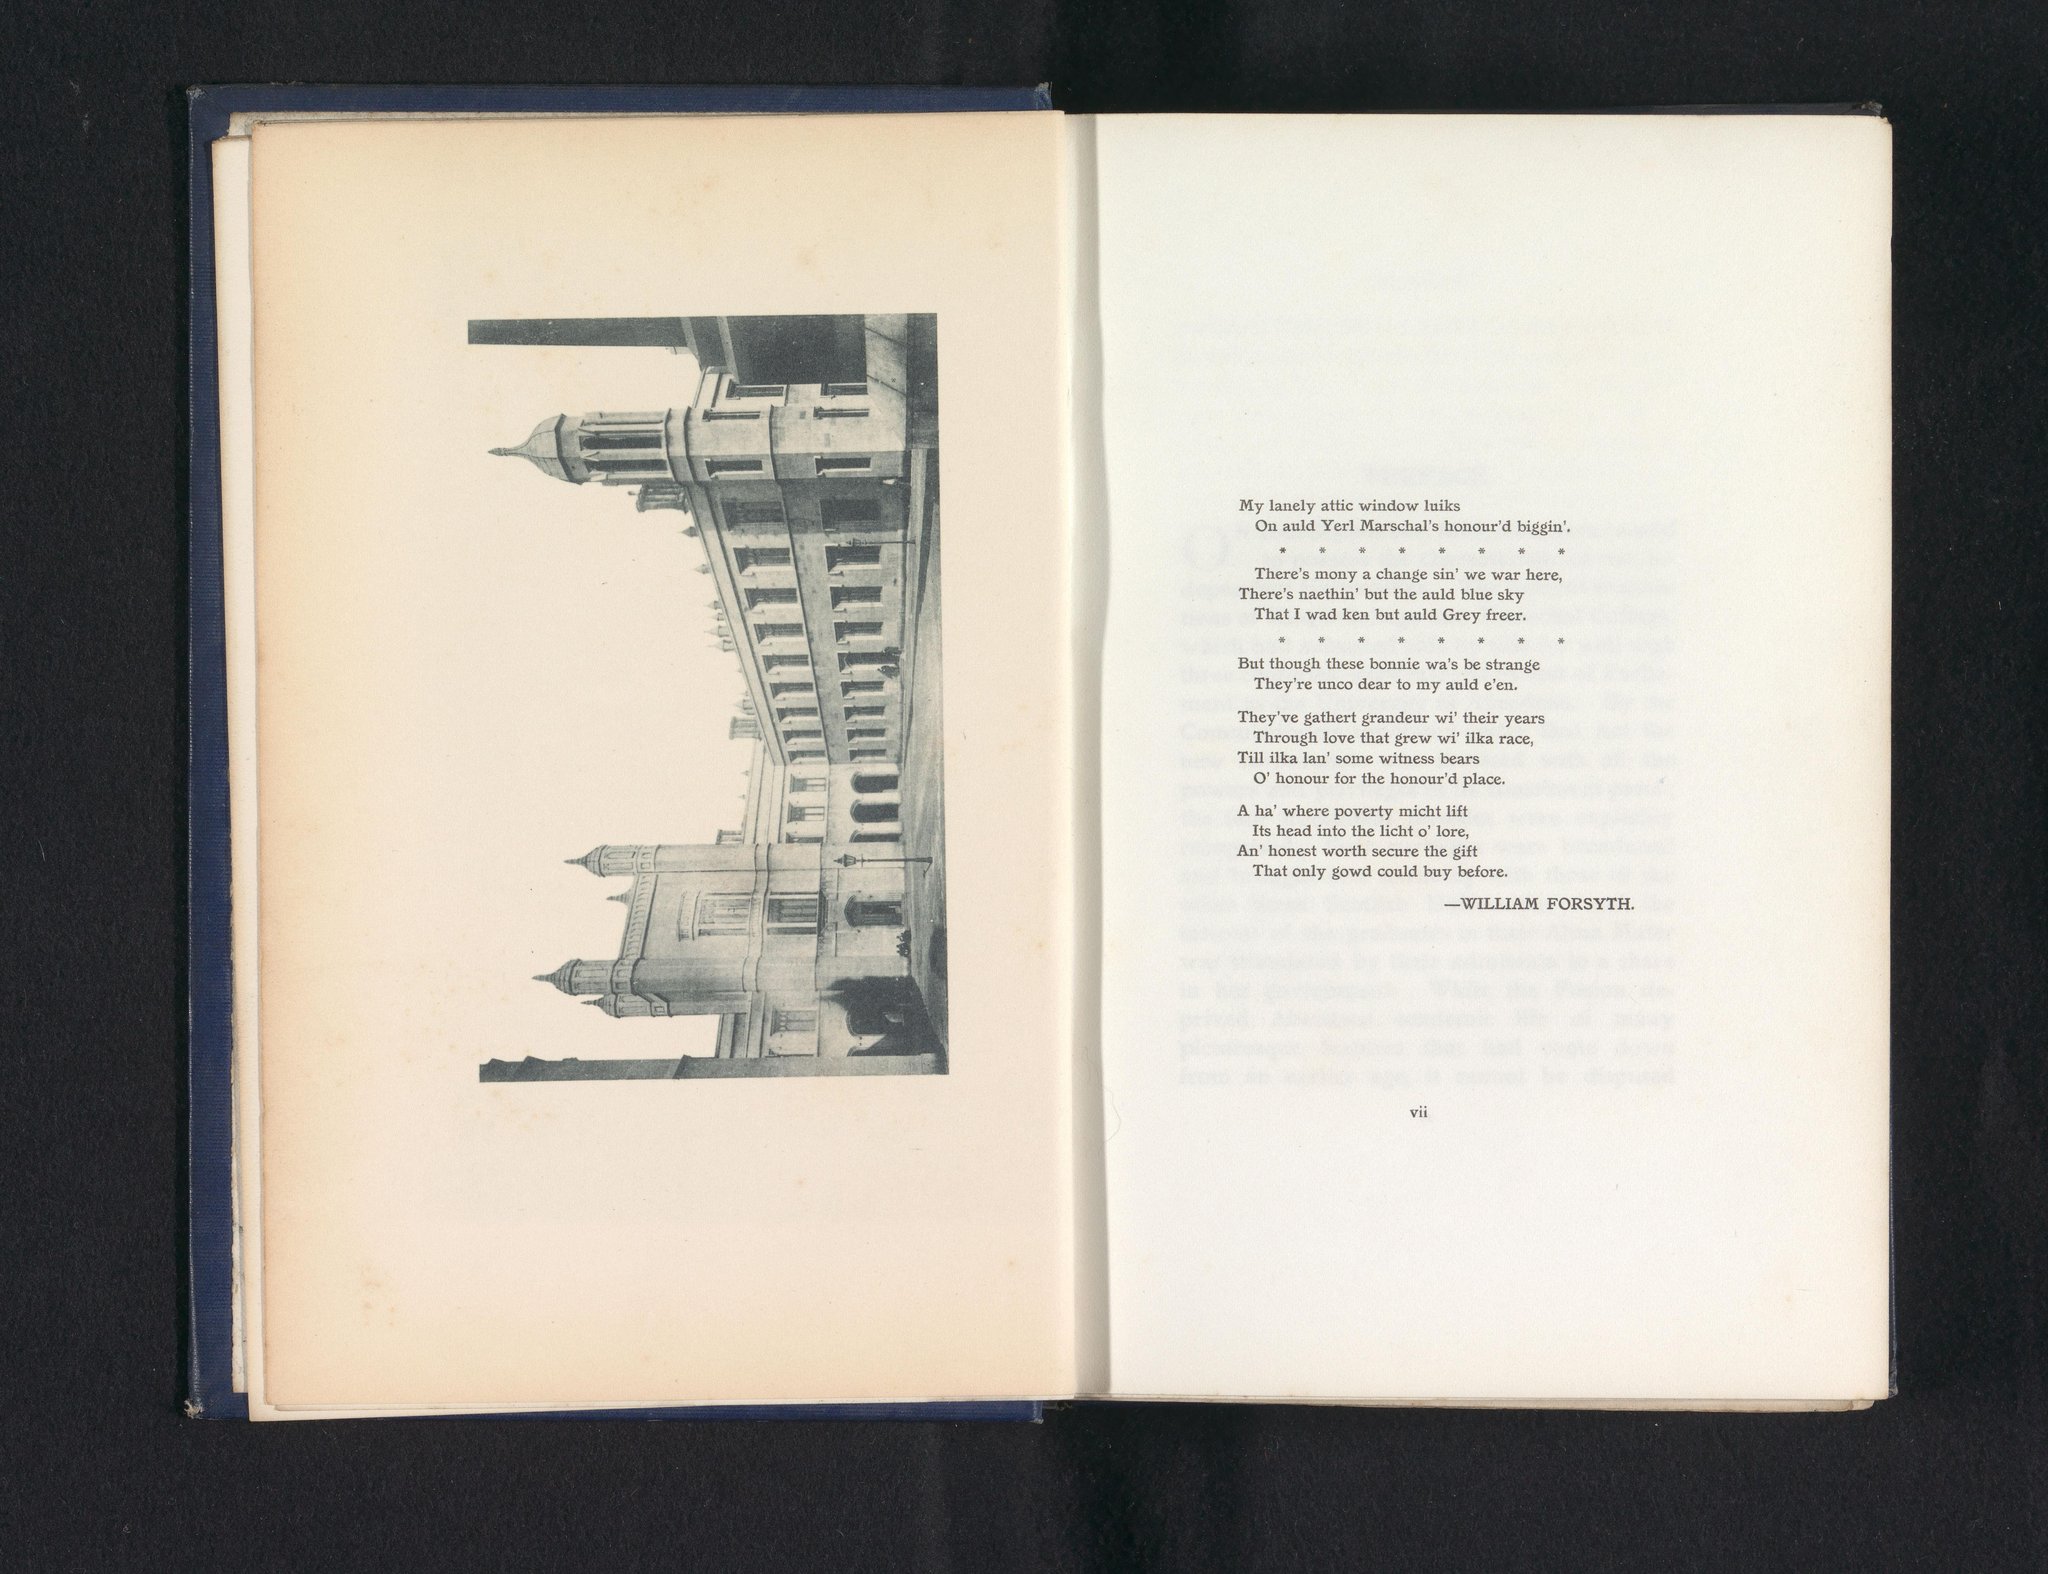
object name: photomechanical print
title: Gezicht op het Marischal College in Aberdeen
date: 1860-1887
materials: paper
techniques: photograph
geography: aberdeen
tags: university